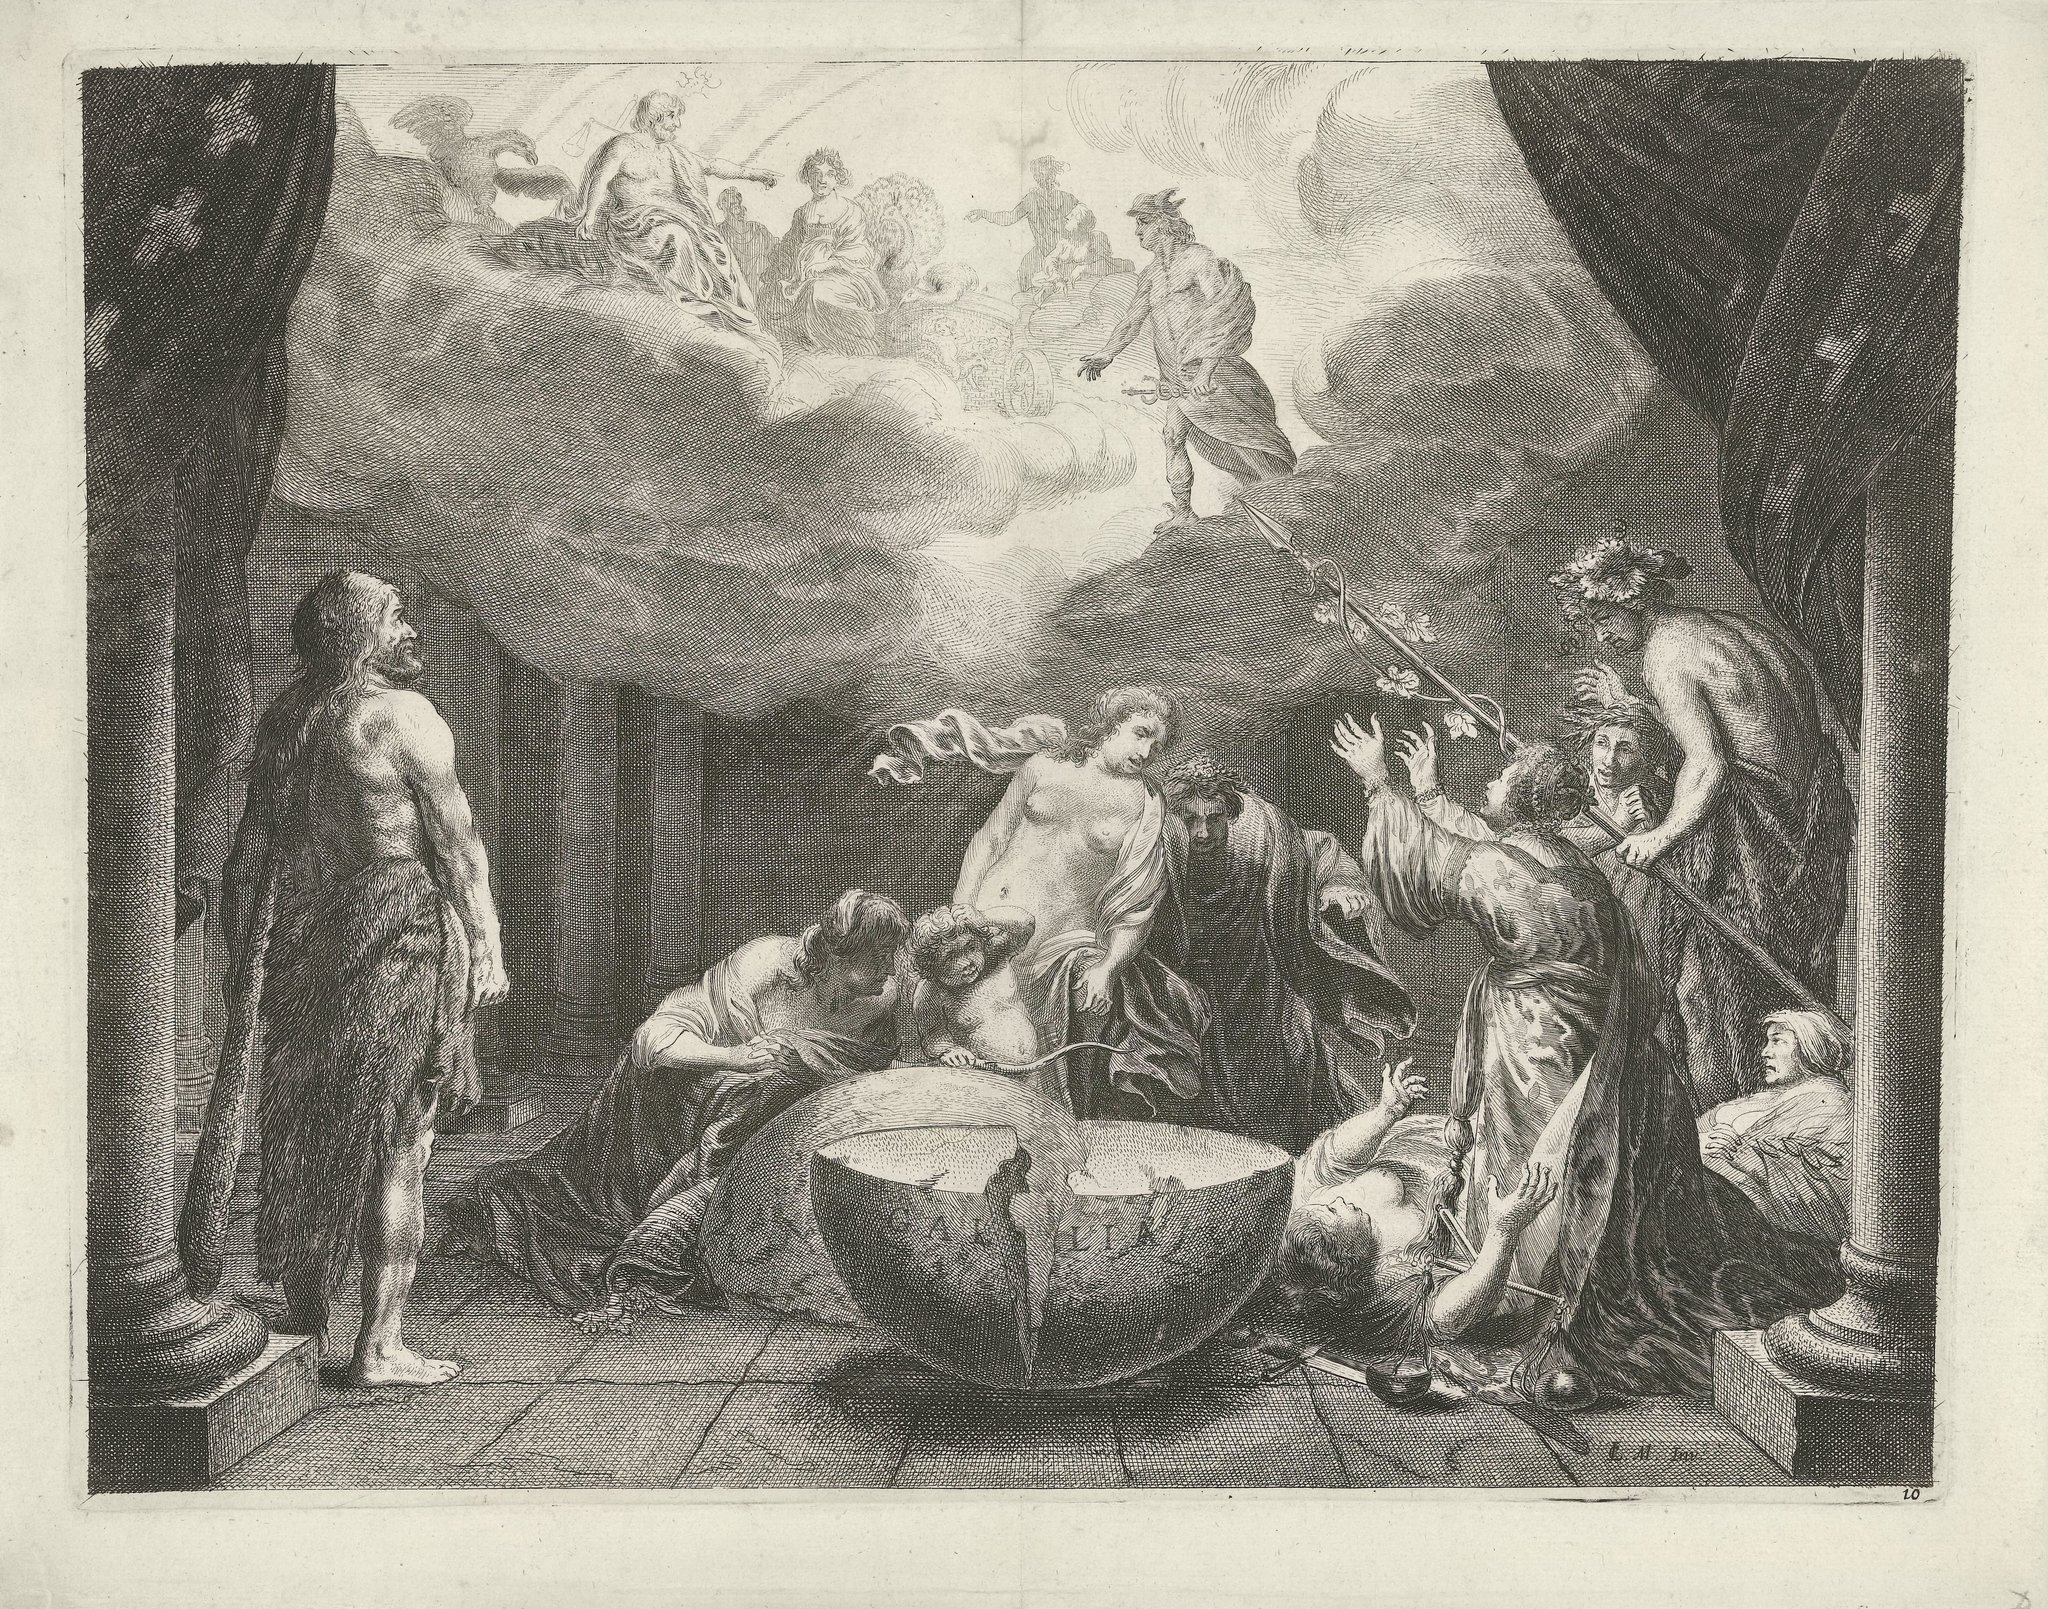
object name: print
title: Franse maagd smeekt de goden om hulp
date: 1638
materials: paper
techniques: engraving, etching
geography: amsterdam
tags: cologne, maria de' medici, hendrik iv (koning van frankrijk en navarra), 'tableau vivant', personifications of countries, nations, states, districts, etc., symbols, allegories of peace, 'pax'; 'pace' (ripa), triumphal entry and public reception, pageant, 'entrée solennelle', 'joyeuse entrée', justice; 'forza alla giustitia sottoposta', 'giustitia', 'giustitia retta', 'giustitia rigorosa', 'impietà e violenza soggetta alla giustitia' (ripa), (story of) venus (aphrodite), amsterdam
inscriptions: collector's mark: Lugt 240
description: Prent ook gebruikt in:* Baerle, Caspar van. Medicea hospes, sive descriptio publicae gratulationis, qua Serenissimam, Augustissimamque Reginam, Mariam de Medicis (…). Amsterdam: Johannes en Cornelis Willemsz. Blaeu, 1638. En in: Baerle, Caspar van. Marie de Medicis, entrant dans Amsterdam : ou, histoire de la reception faicte à la Reyne Mere du Roy tres-Chrestien (…). Amsterdam: Johannes en Cornelis Willemsz. Blaeu, 1638. En in: Baerle, Caspar van en Joost van den Vondel. Blyde inkomst der allerdoorluchtighste koninginne, Maria de Medicis t' Amsterdam. Vertaelt uit het Latijn (…). Amsterdam: Johannes en Cornelis Willemsz. Blaeu, 1639. * Doorgaans zijn de prenten in de bovengenoemde publicaties rechtsonder genummerd (van de huidige prent is dat de derde bekende staat). Maar er zijn ook exemplaren waarin eerdere, ongenummerde, staten van de prenten (van de huidige prent de eerste en tweede bekende staat) zijn ingebonden.